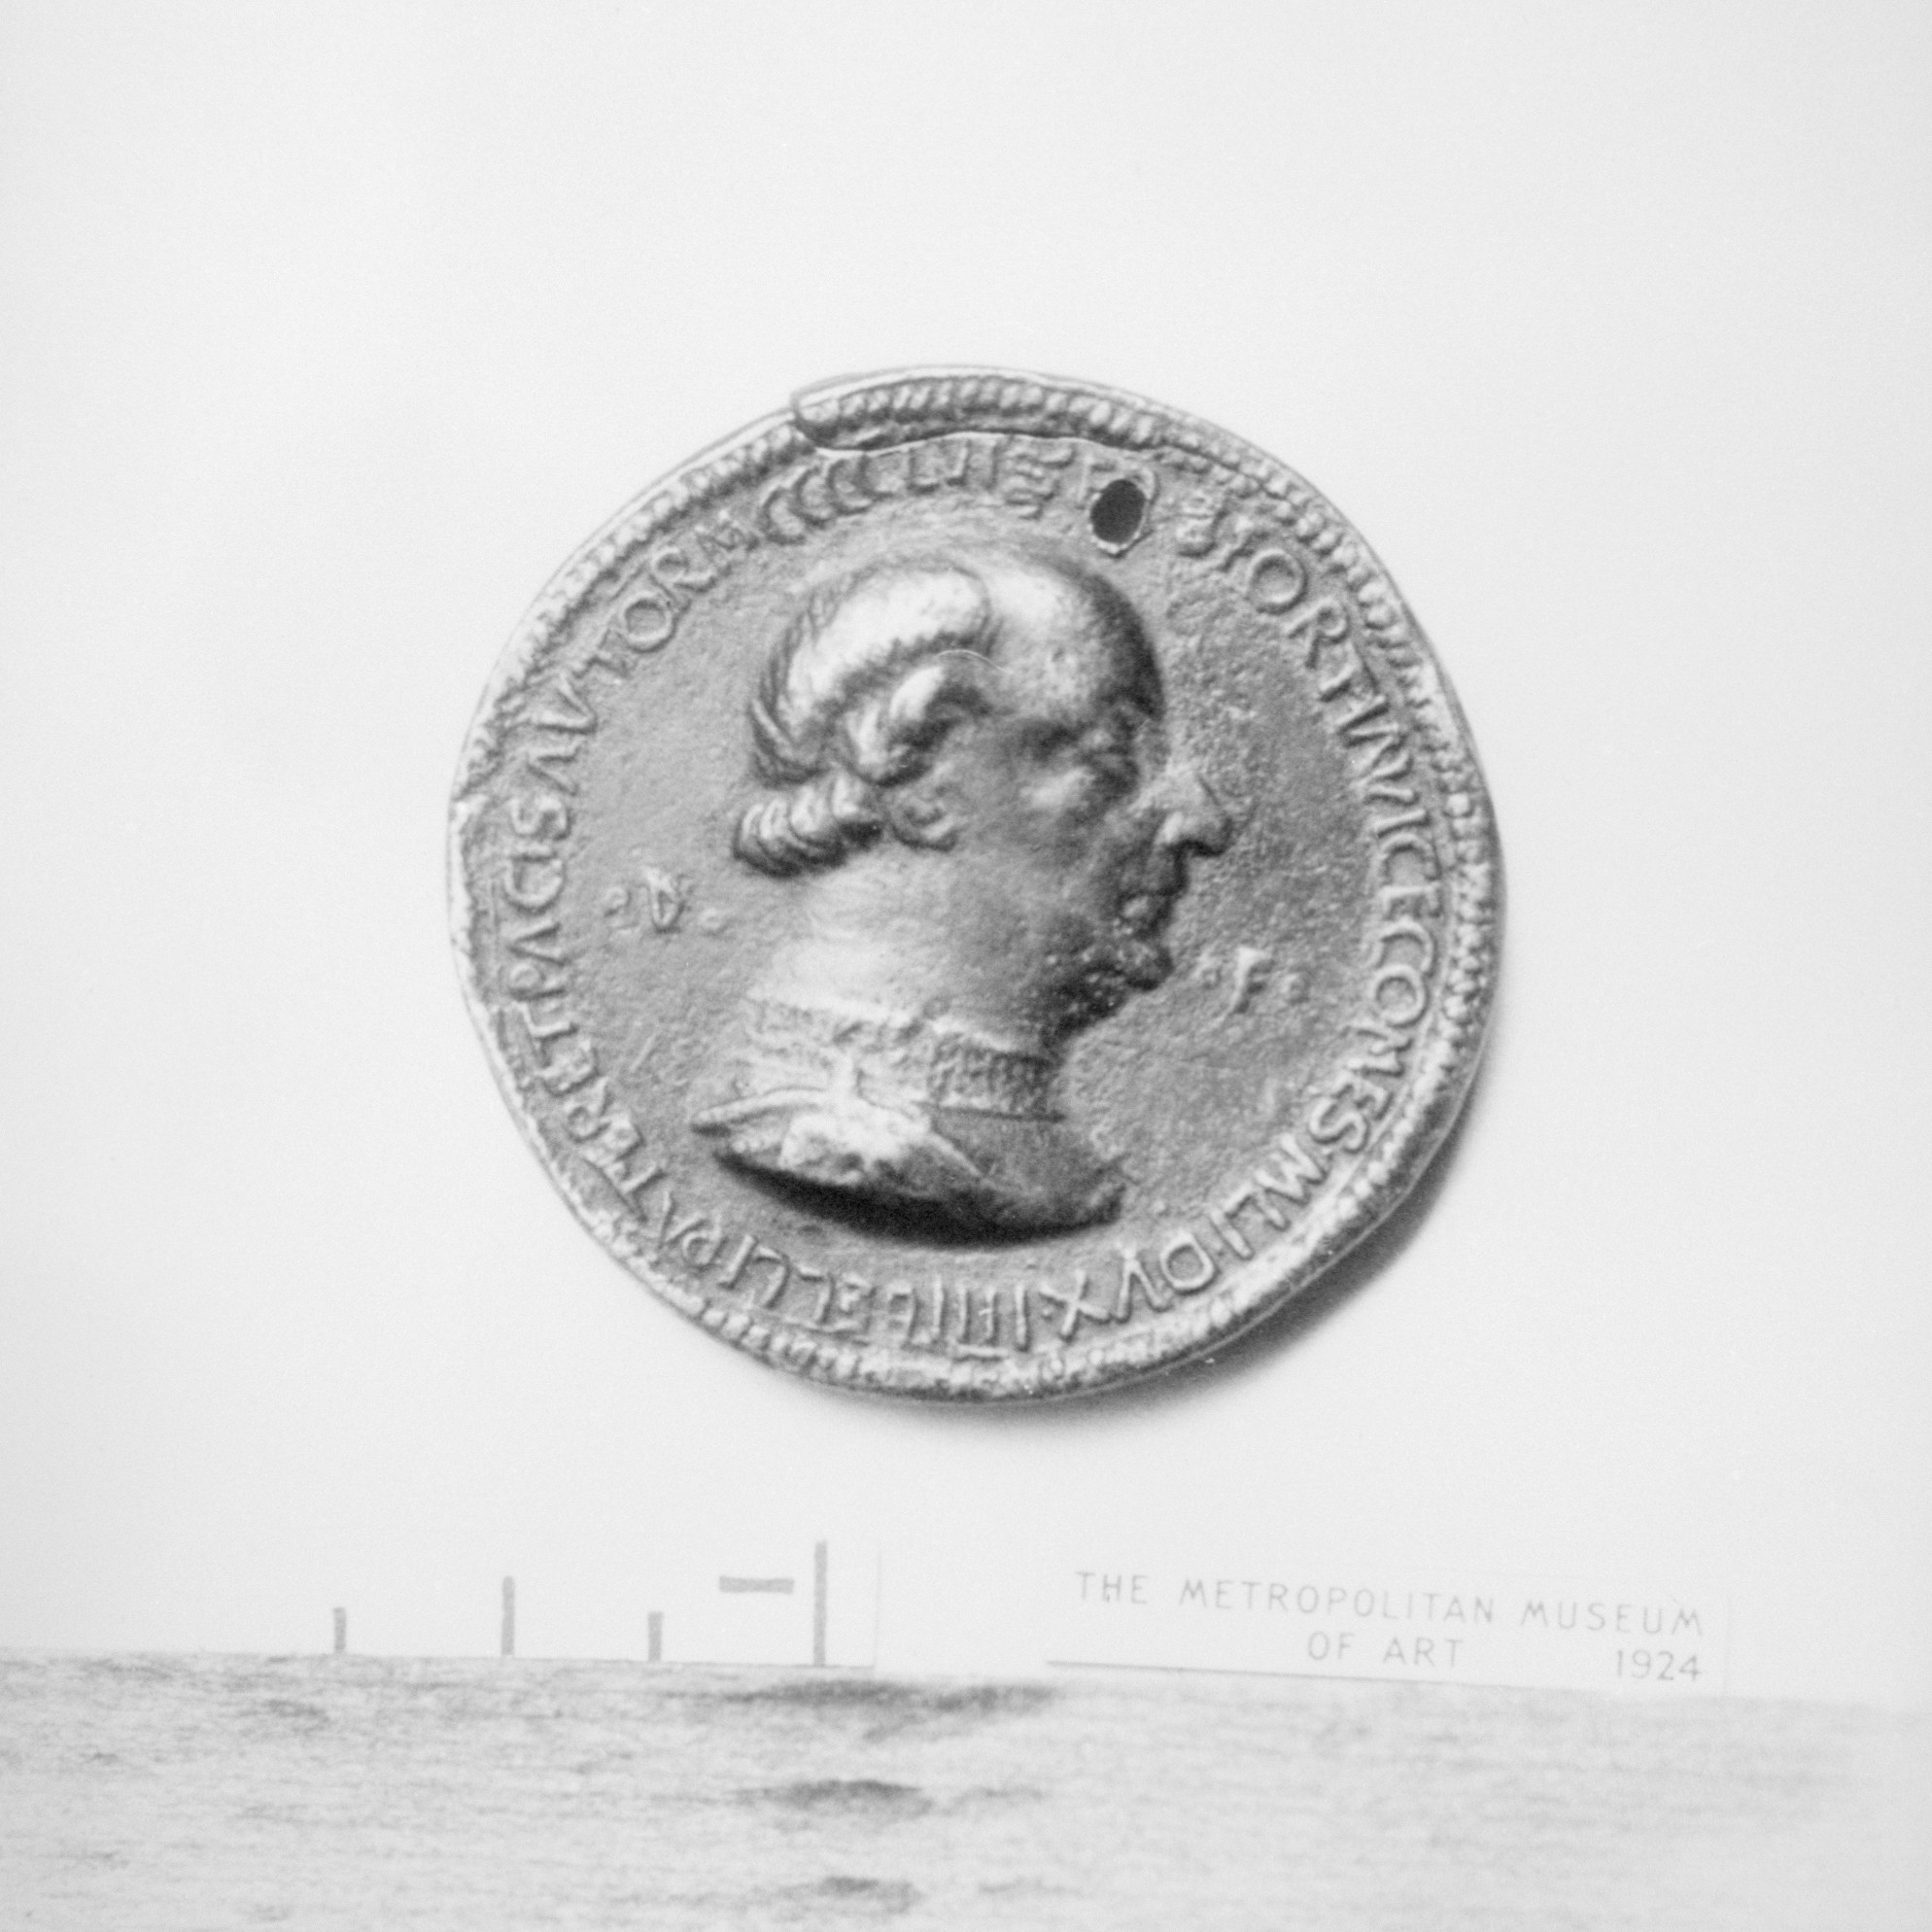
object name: medal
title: Francesco and Galeazzo Maria Sforza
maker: gian francesco enzola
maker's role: artist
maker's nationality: italian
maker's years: 1456-1478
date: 1401-1500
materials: bronze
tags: men,profiles